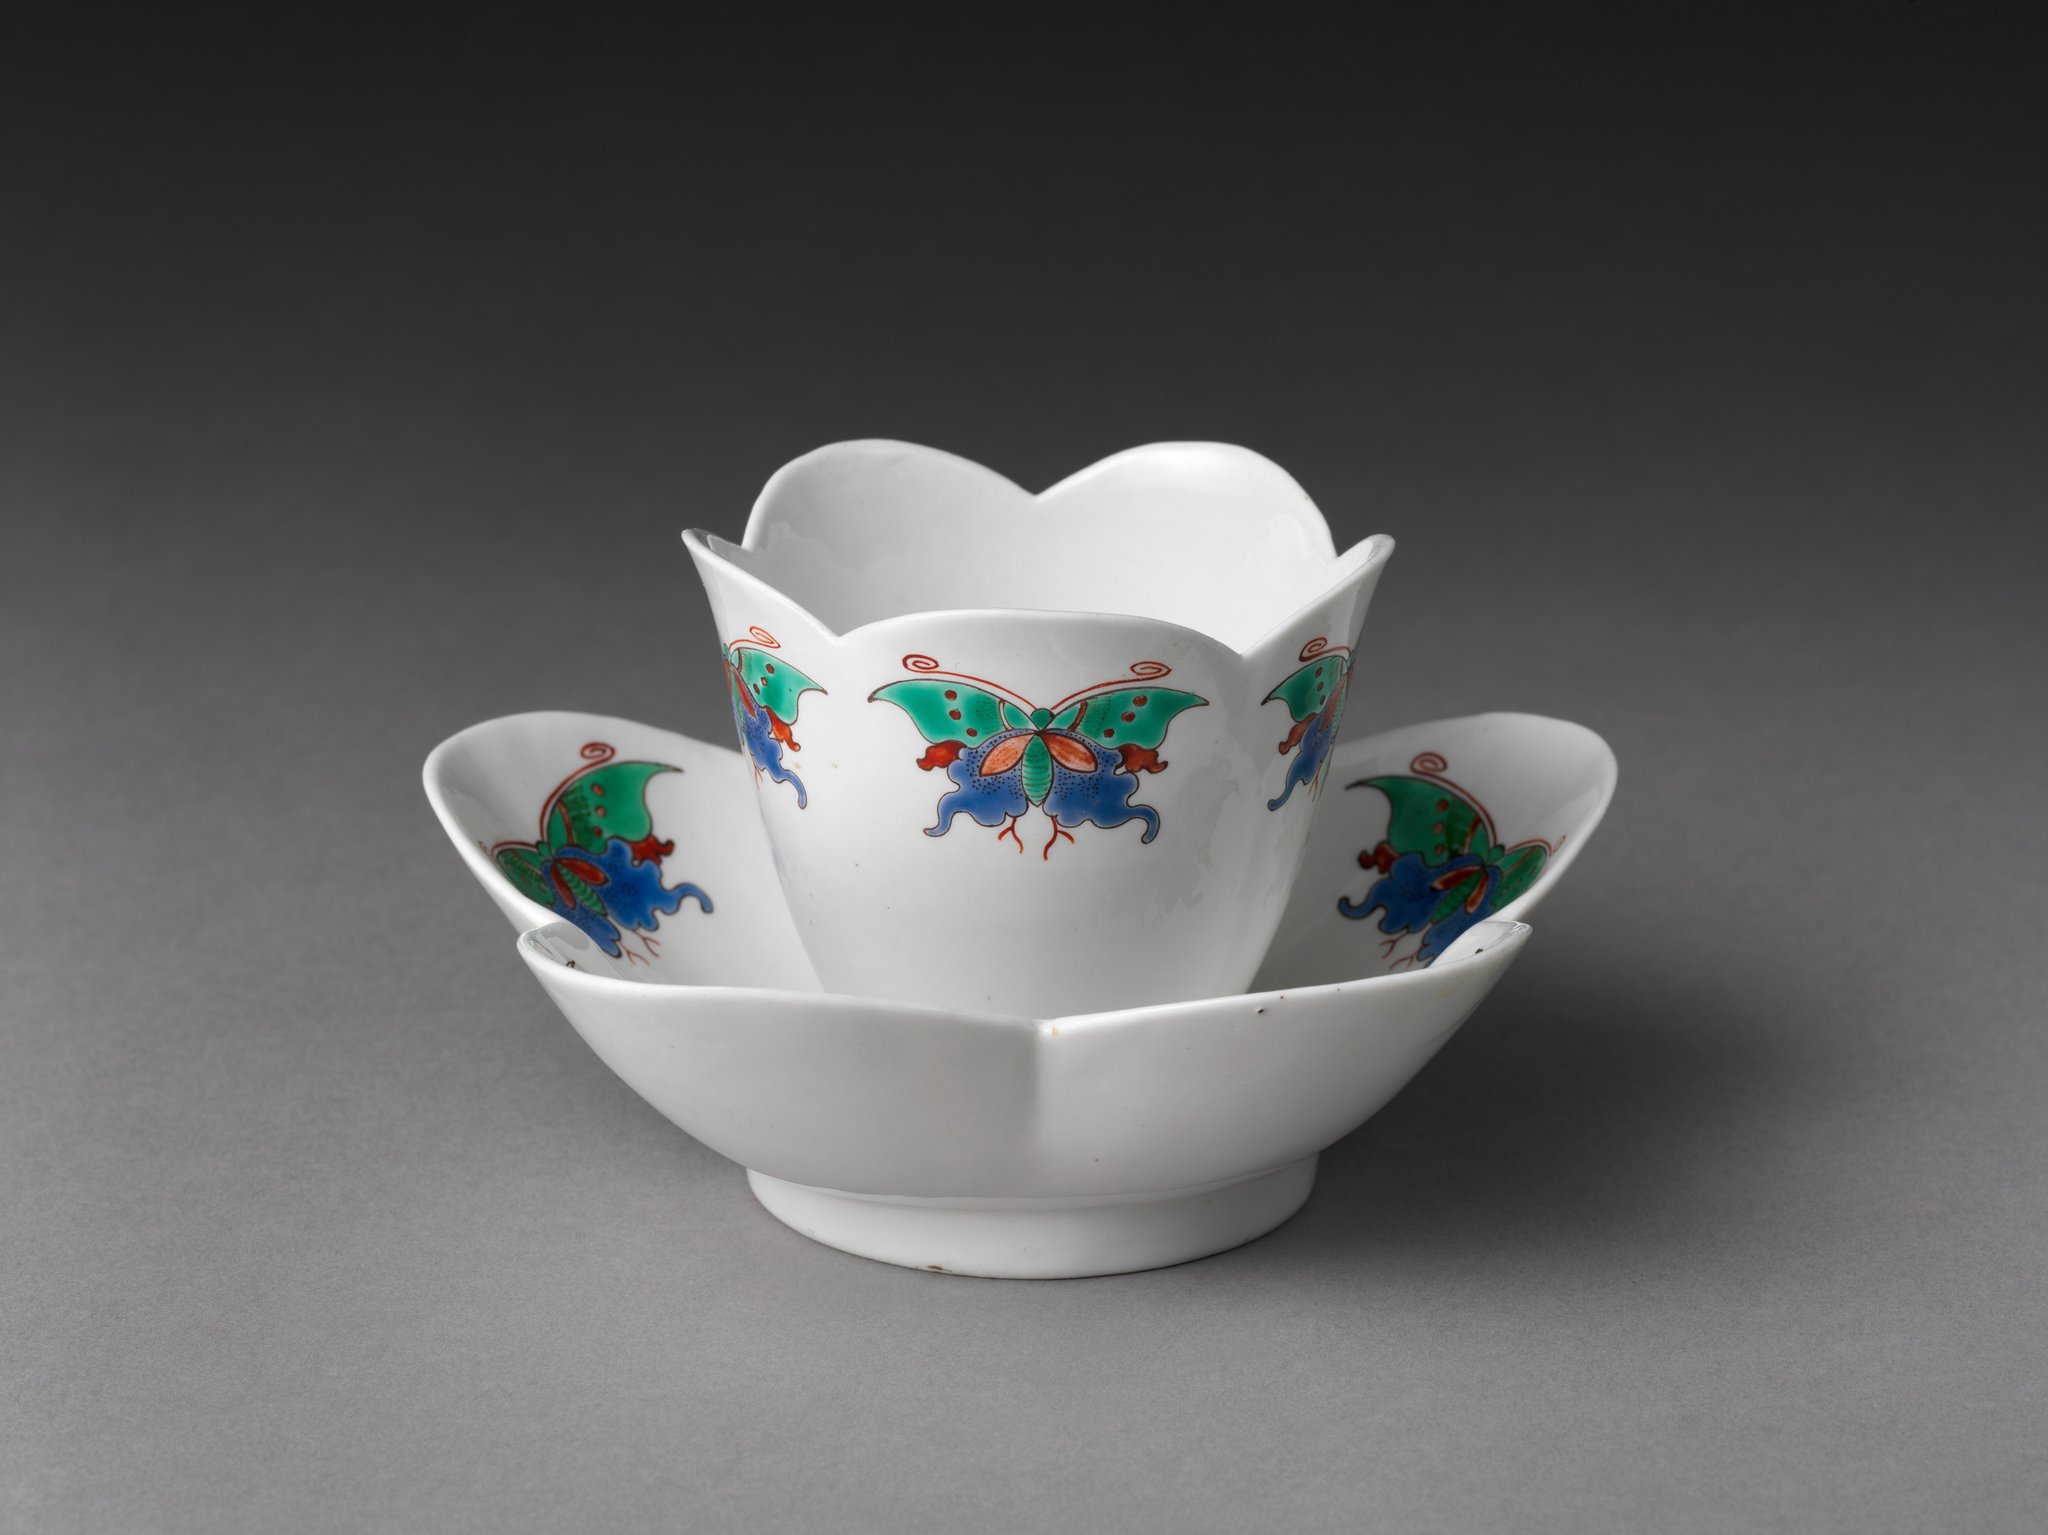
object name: cup and saucer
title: Cup and saucer with butterflies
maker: chantilly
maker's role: factory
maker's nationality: french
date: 1735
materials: enamel, soft paste porcelain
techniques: painting, glazing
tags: butterflies